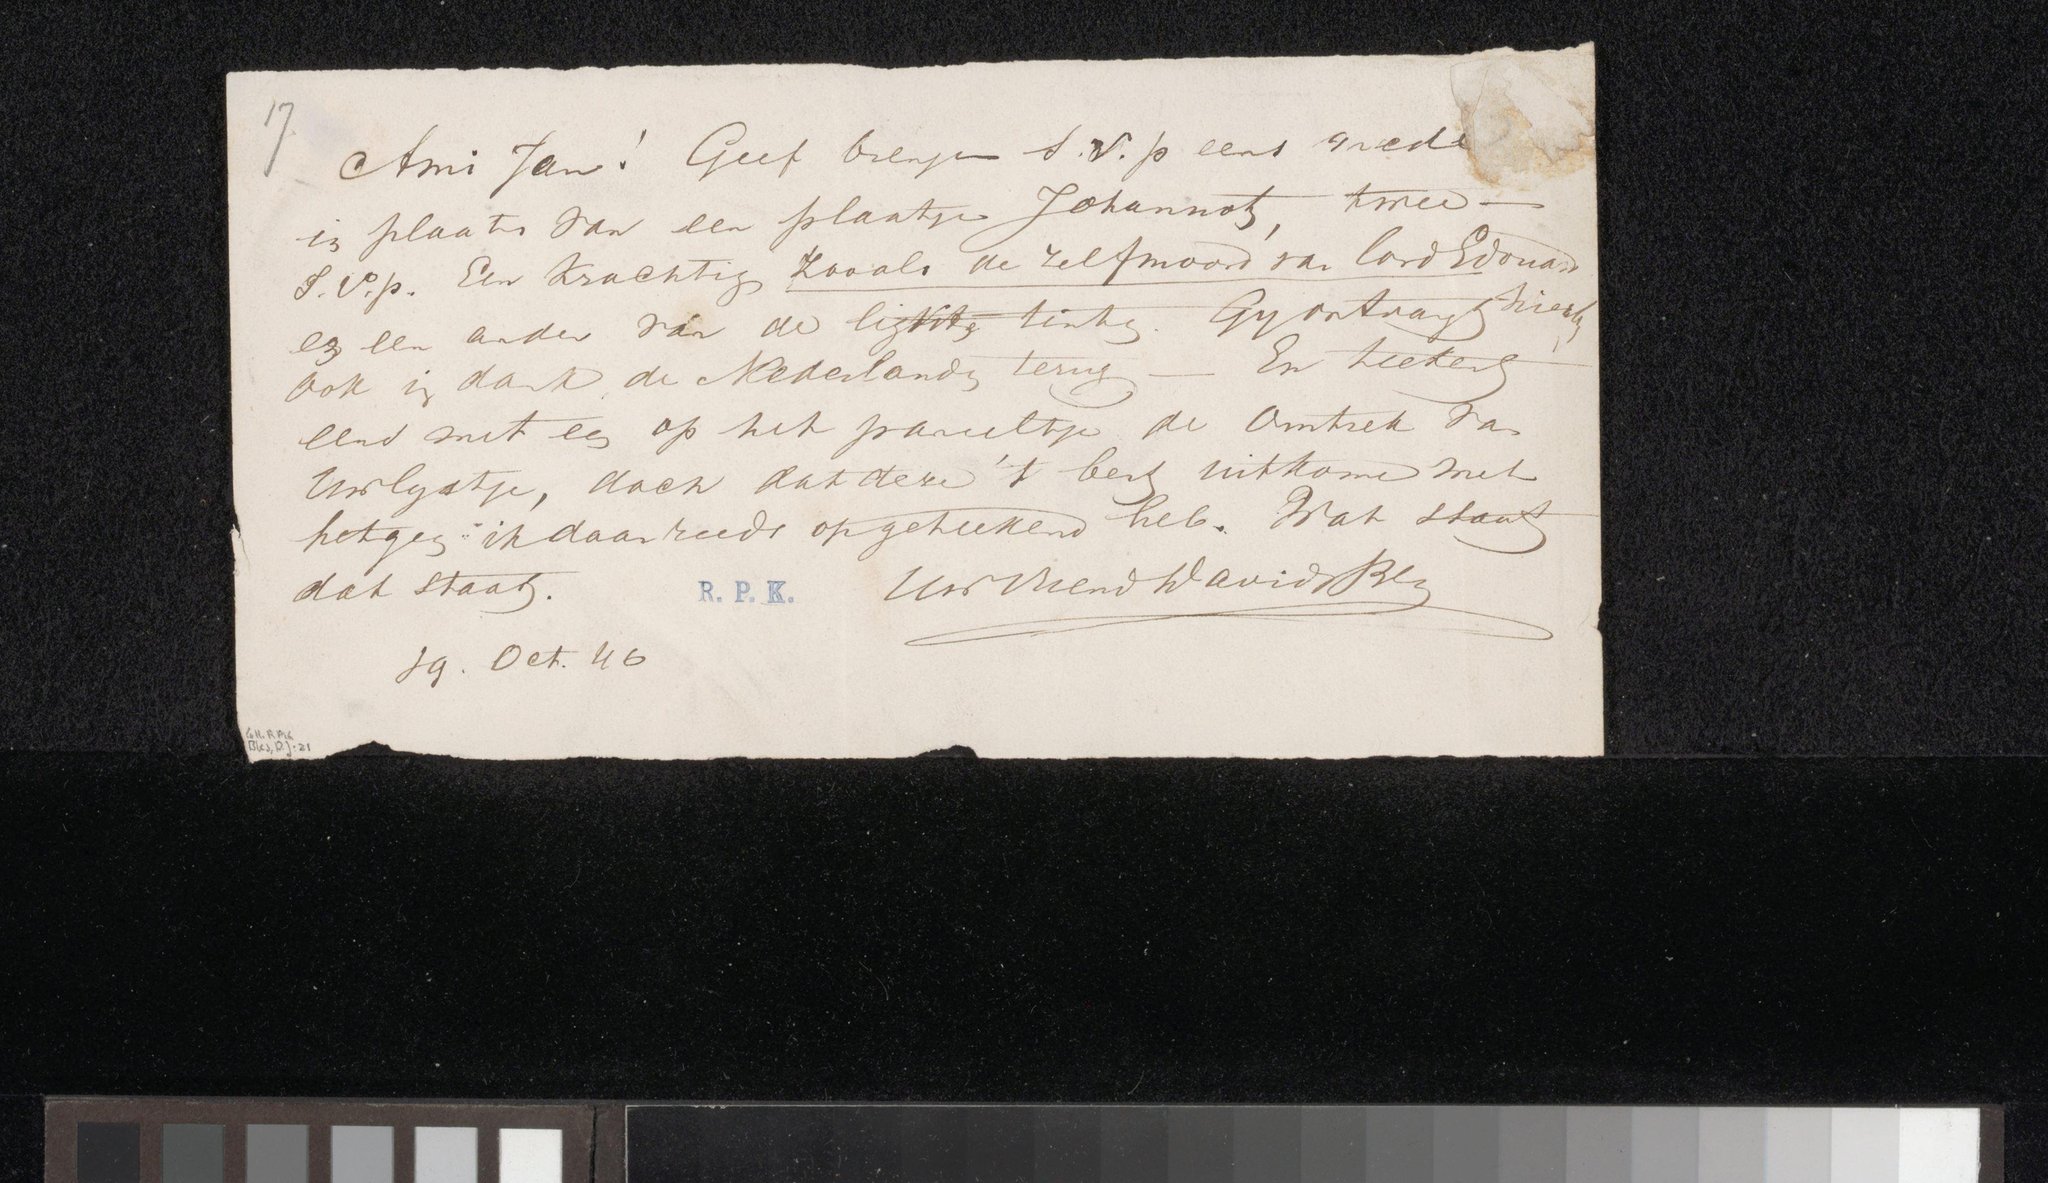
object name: letter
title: Brief aan Jan Weissenbruch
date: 1846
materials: ink, paper, pencil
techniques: pen, writing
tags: jan weissenbruch, anonymous historical person portrayed (+ profile portrait), anonymous historical person portrayed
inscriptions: collector's mark: Lugt 2233